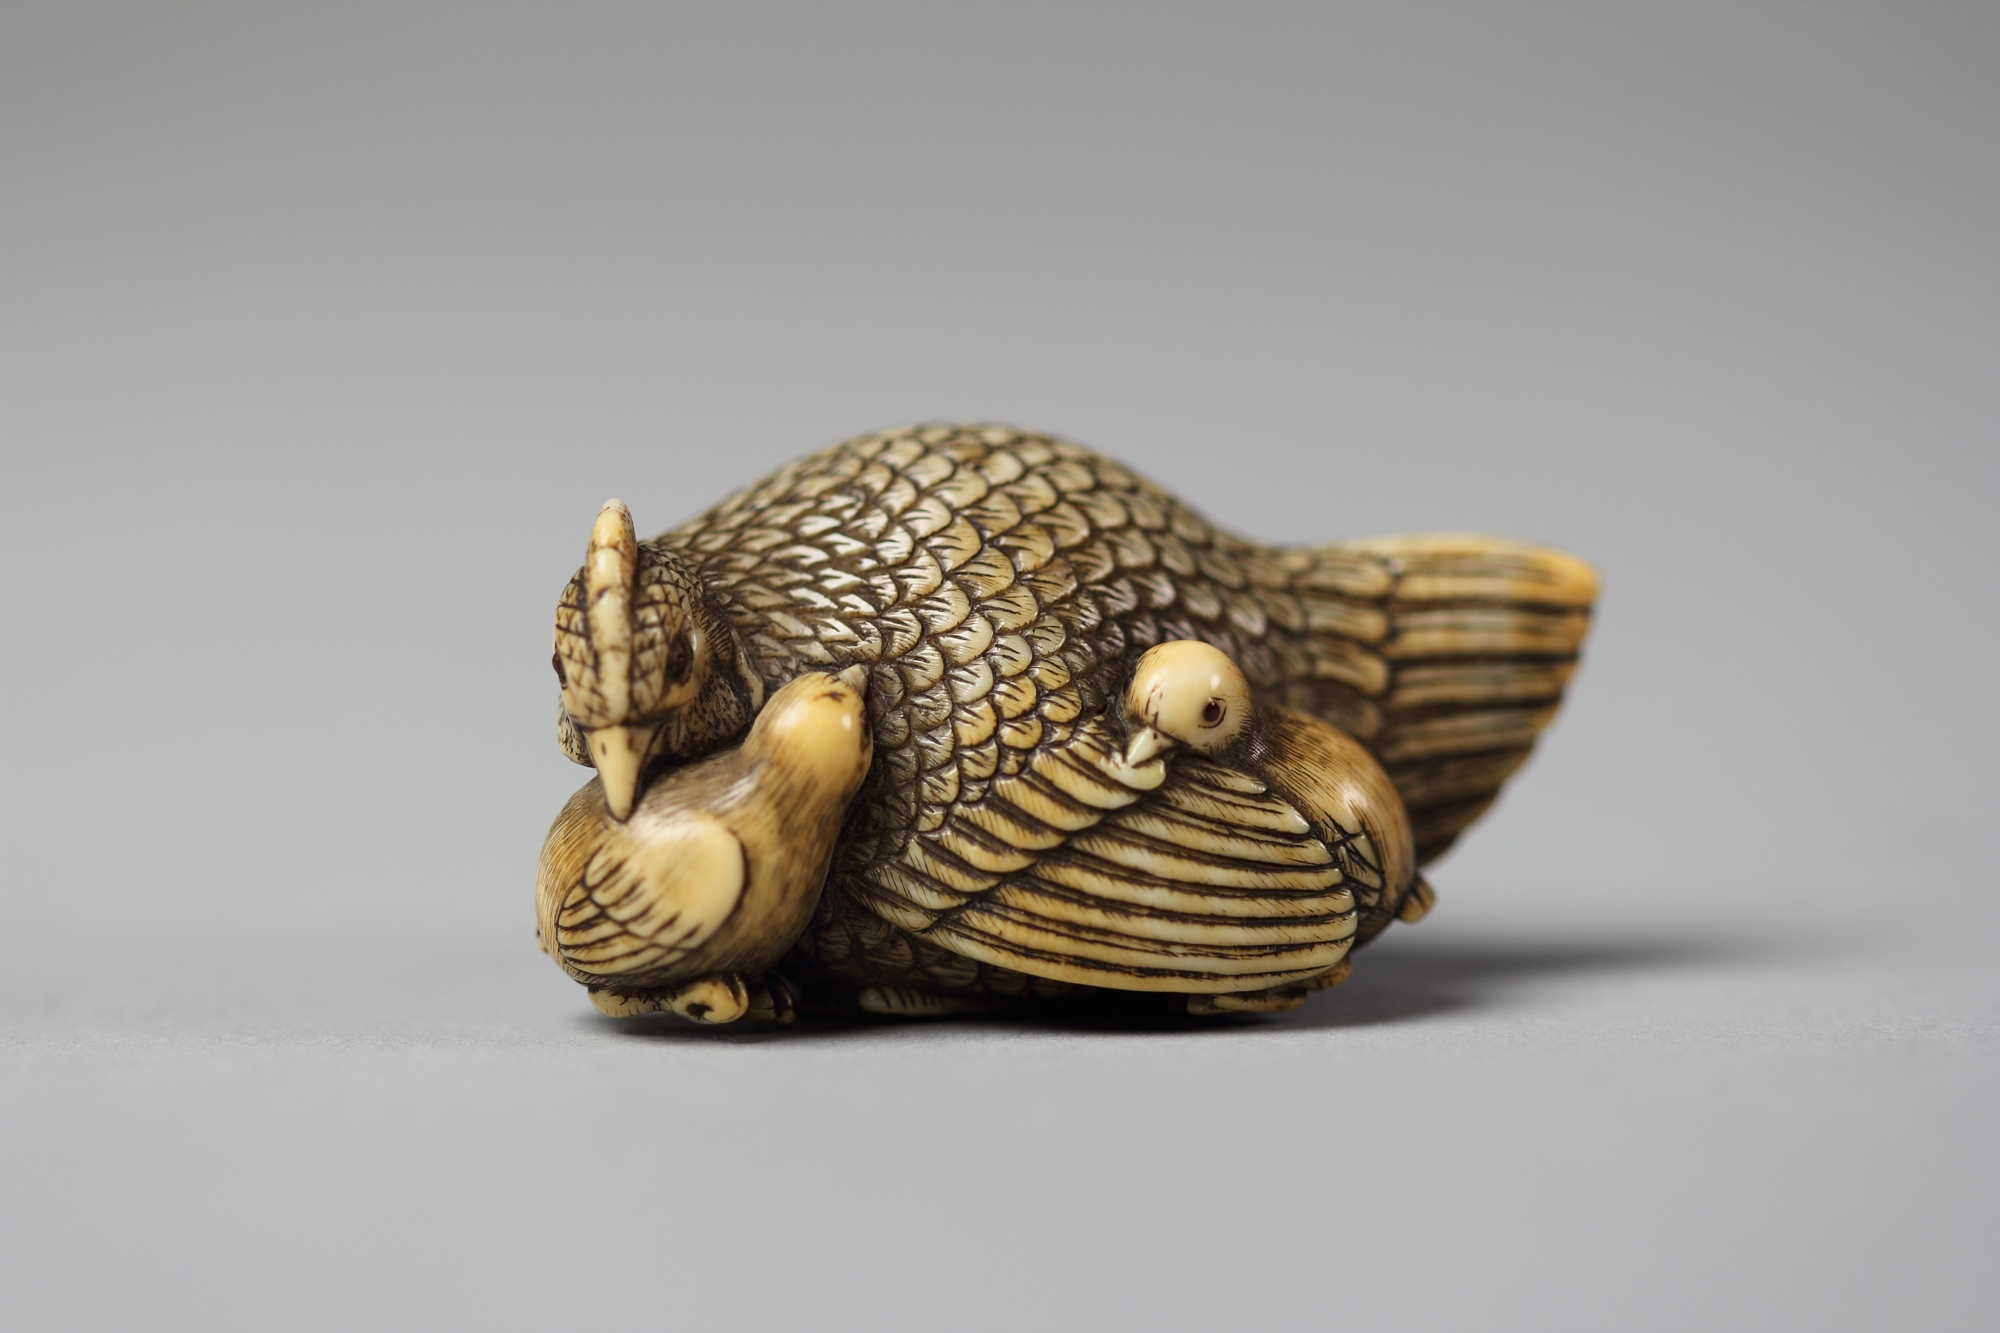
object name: netsuke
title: Netsuke of Hen and Two Small Chicks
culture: japanese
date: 1701-1900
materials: ivory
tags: chickens